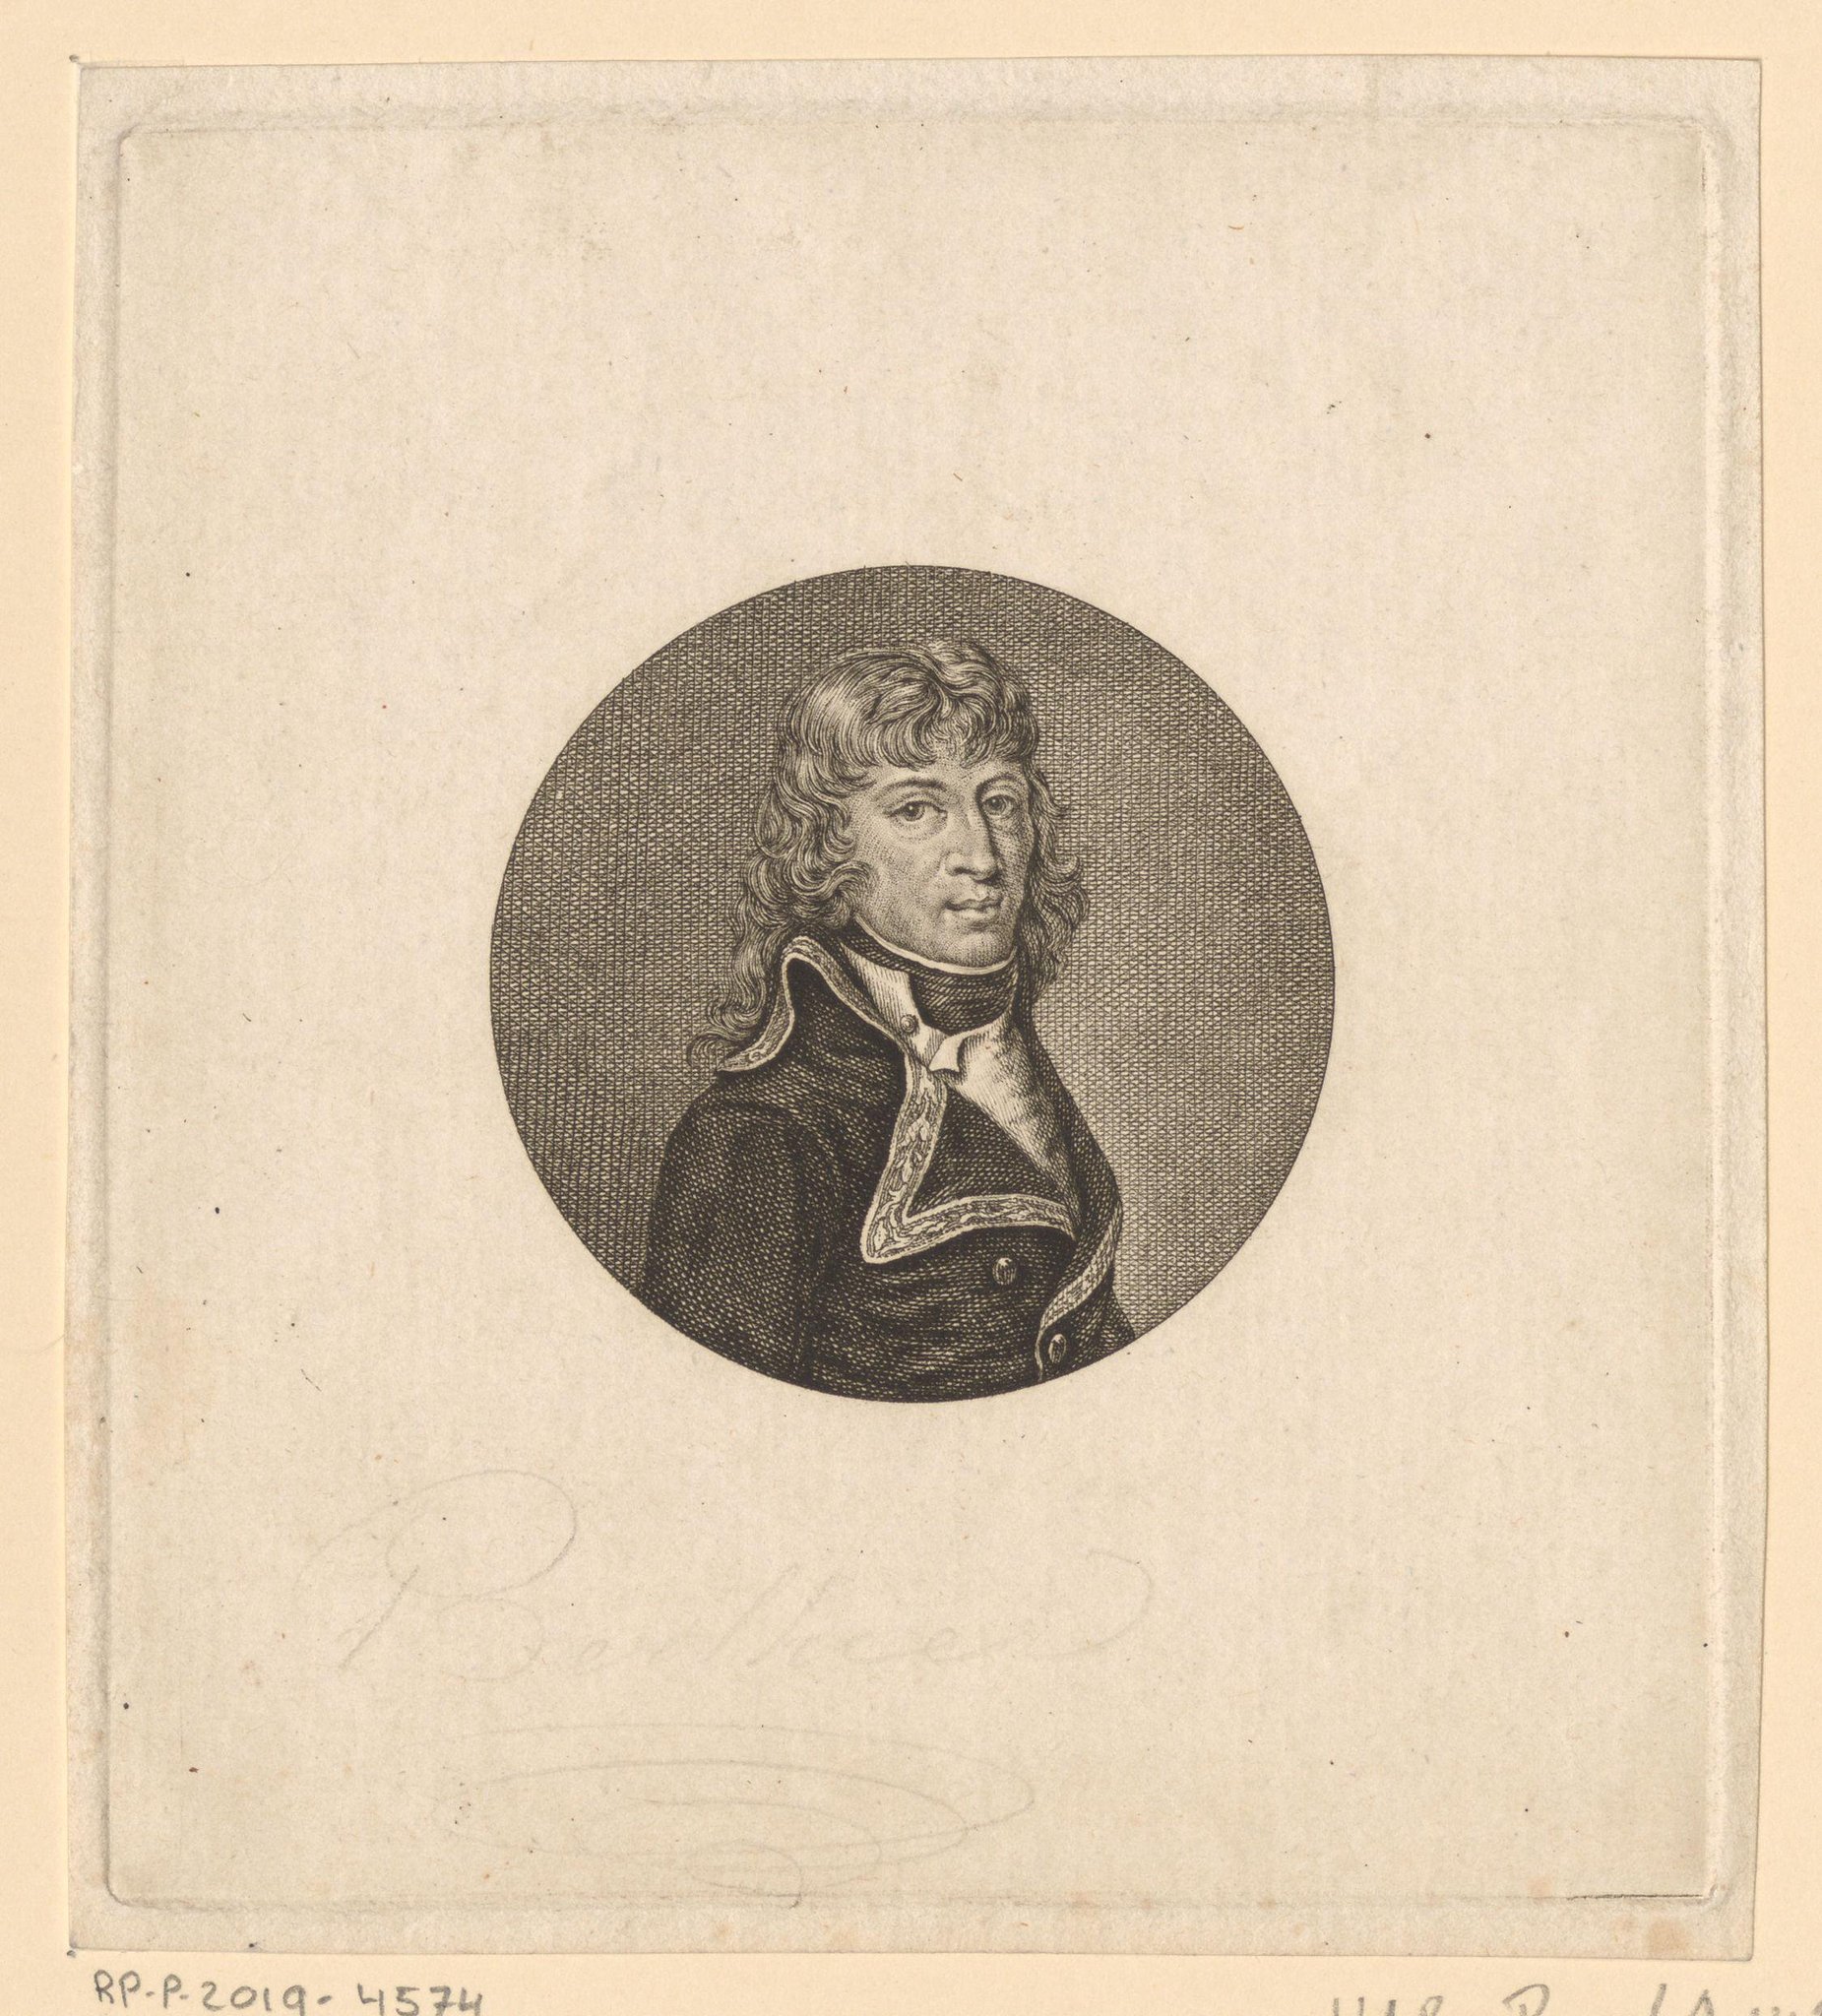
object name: print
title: Portret van Louis-Alexandre Berthier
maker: Anonymous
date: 1800-1849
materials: paper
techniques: engraving, etching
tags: historical persons